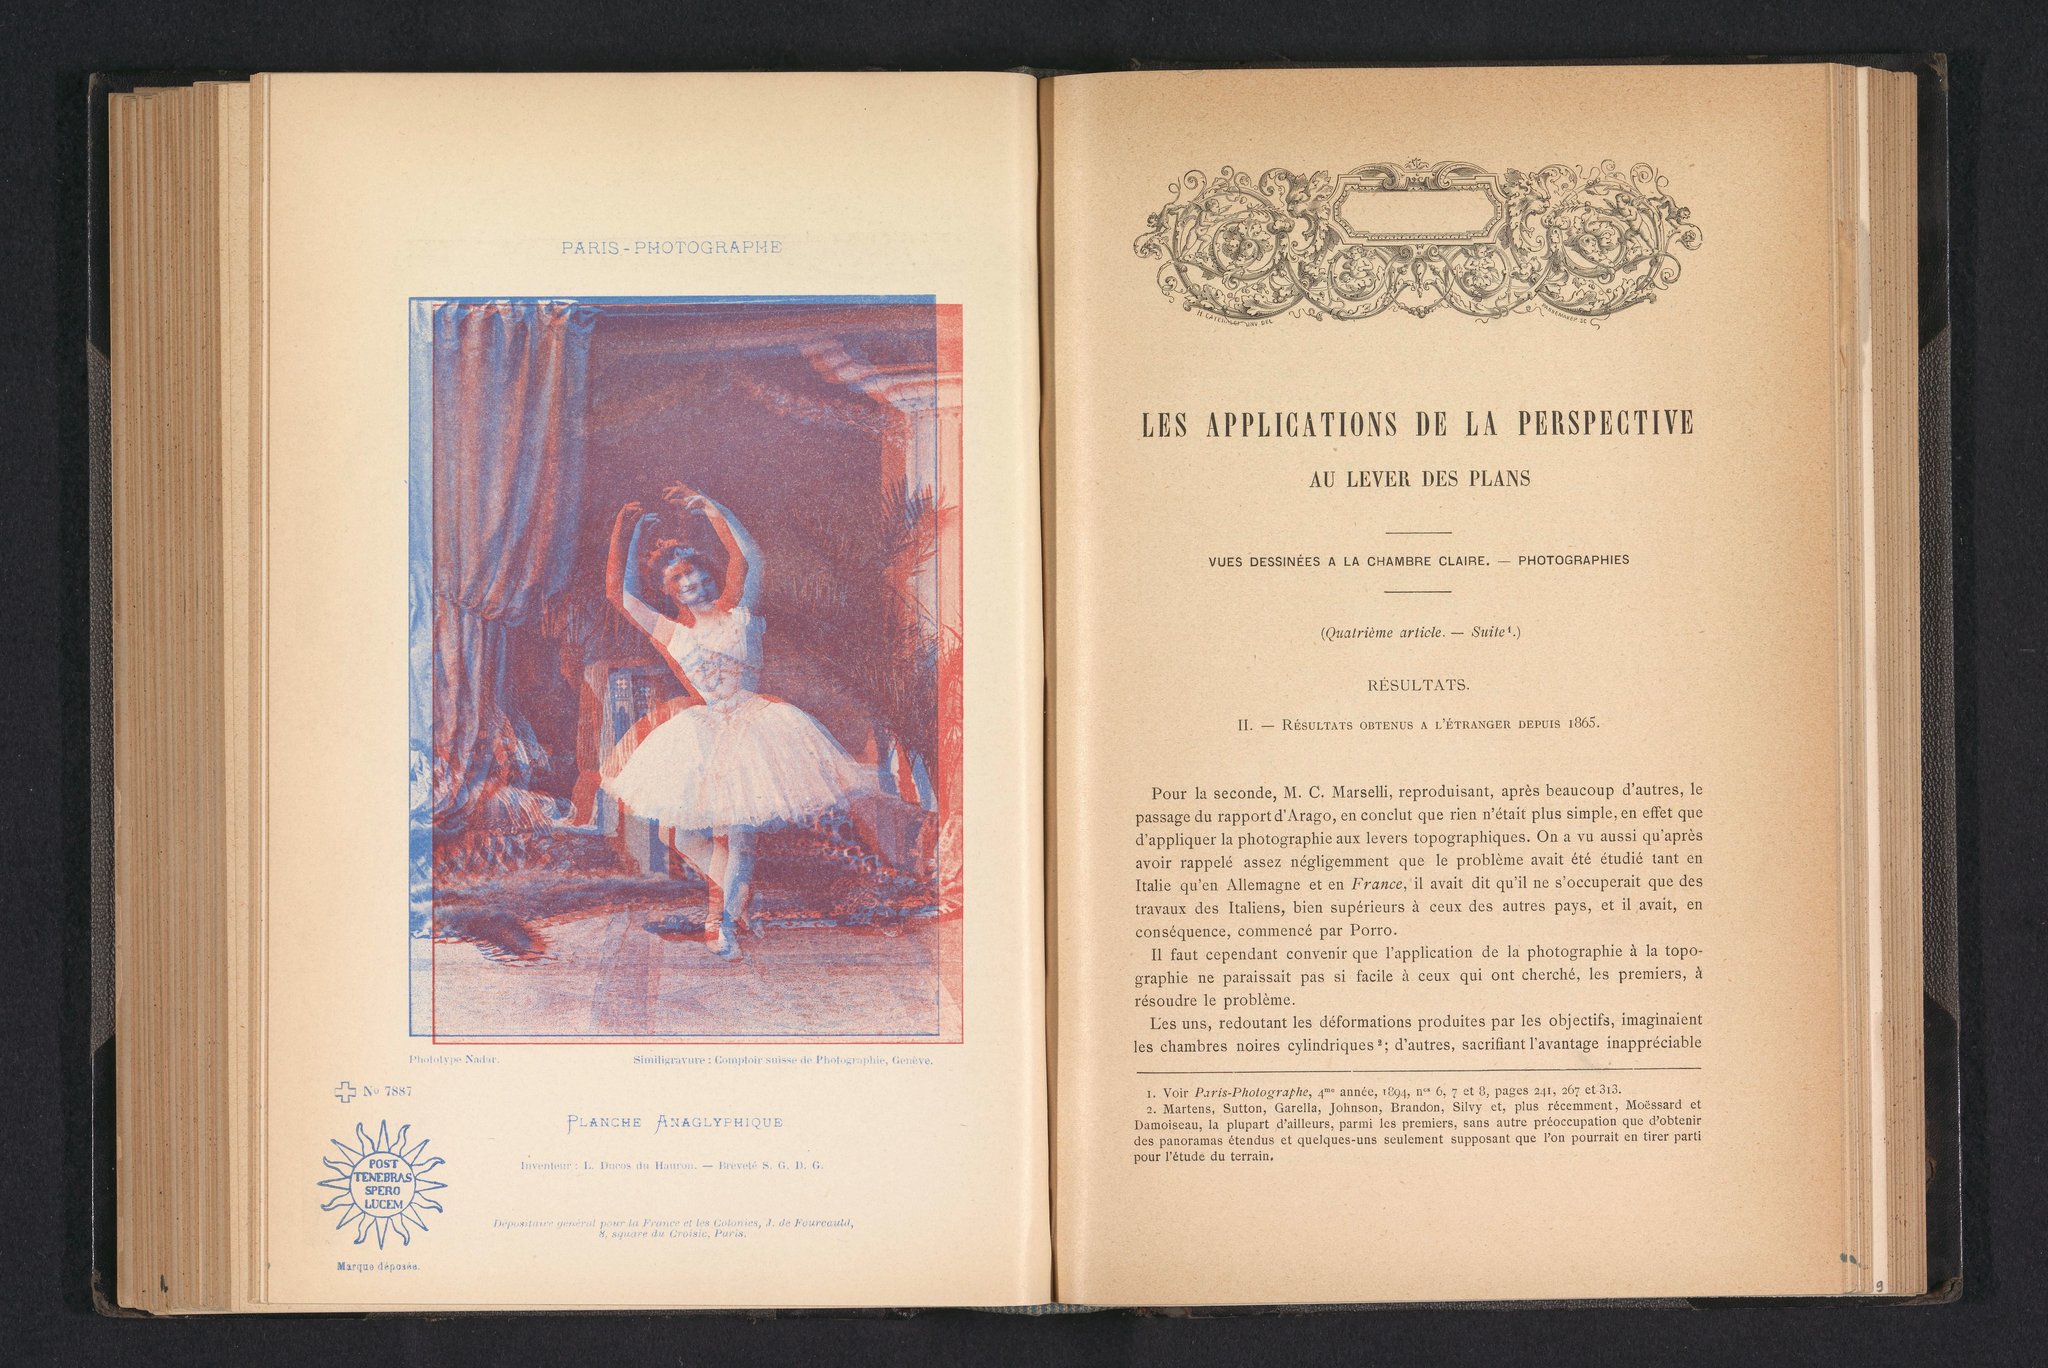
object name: page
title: Planche anaglyphique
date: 1884-1894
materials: paper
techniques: autotype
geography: france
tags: female dancer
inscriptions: inscription: ‘Inventeur: L. Ducos du Hauron. - Breveté S.G.D.G. (...)’